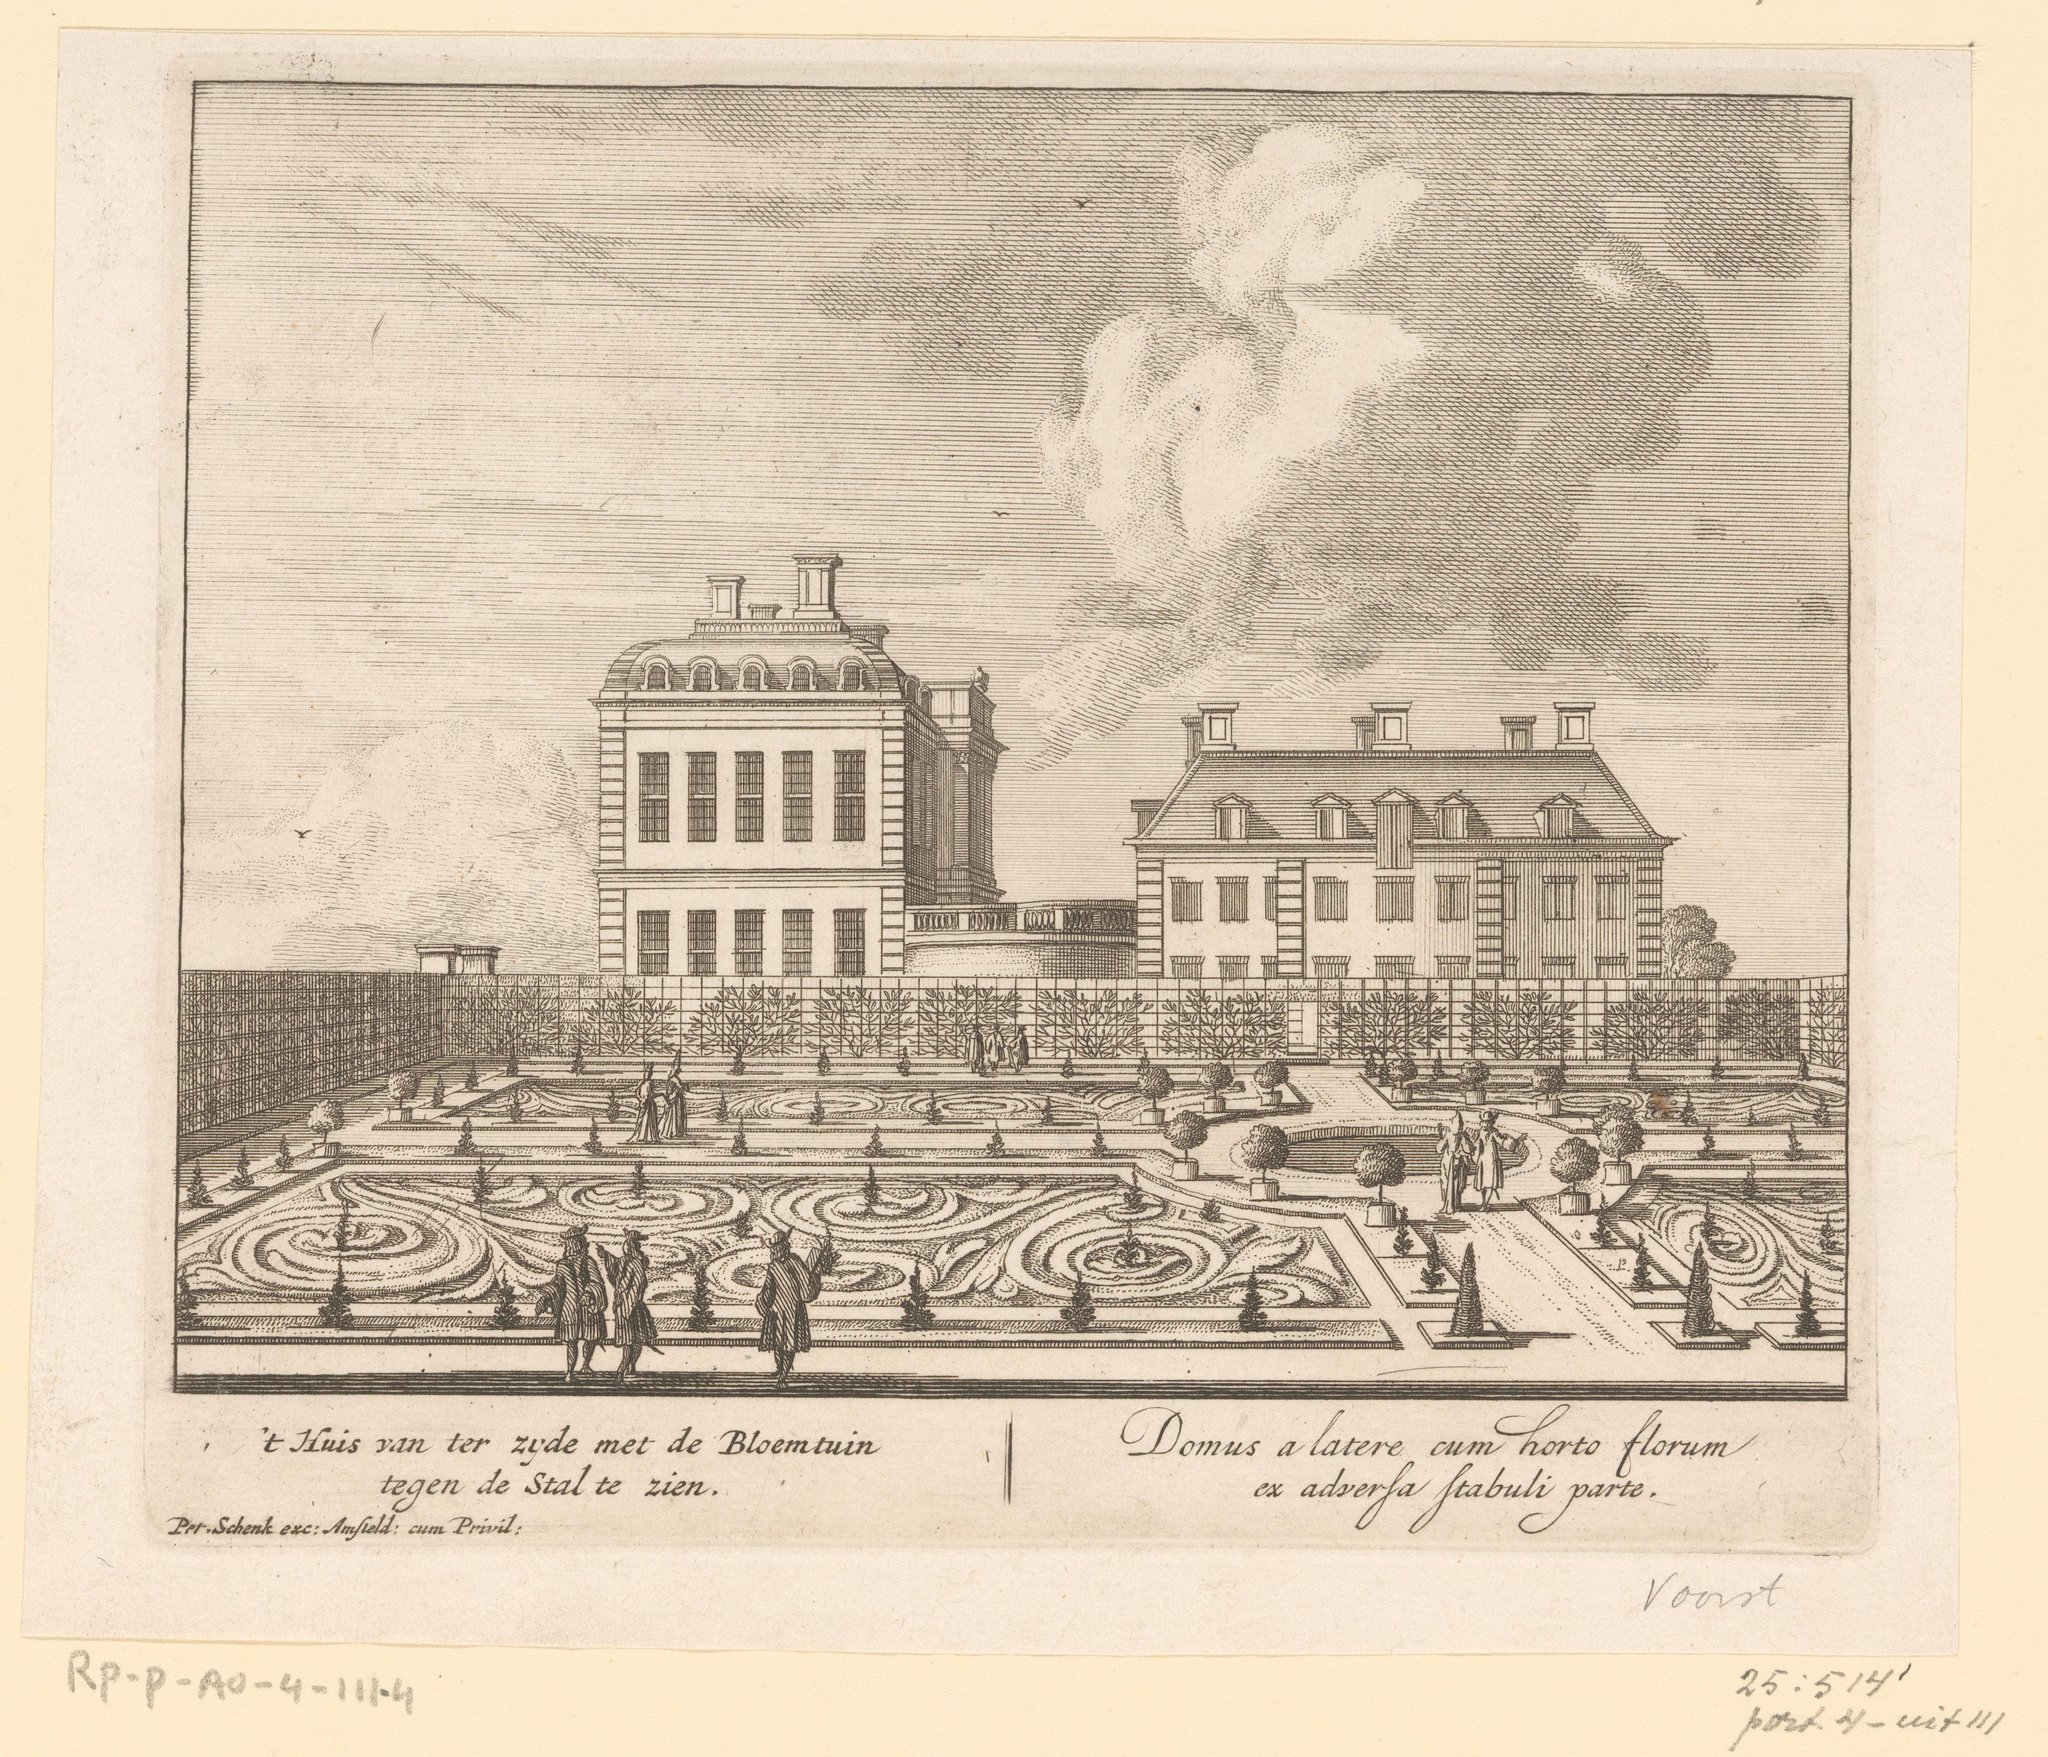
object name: print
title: Gezicht op Huis de Voorst van de zijkant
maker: pieter schenk (i)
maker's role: print maker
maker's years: 1660-1711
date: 1700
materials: paper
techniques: engraving, etching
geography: amsterdam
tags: palace, french or architectonic garden; formal garden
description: Prent is uitgeven door Pieter Schenk (I) als onderdeel van de zestiendelige prentserie 'Praetorium Dieranum', ca. 1700. Later is de prent ook gebruikt in: Schenk, Pieter (I). Paradisus Oculorum: sive conspectus degantissimi centum (...). Jacobus Romanus, ca. 1700.